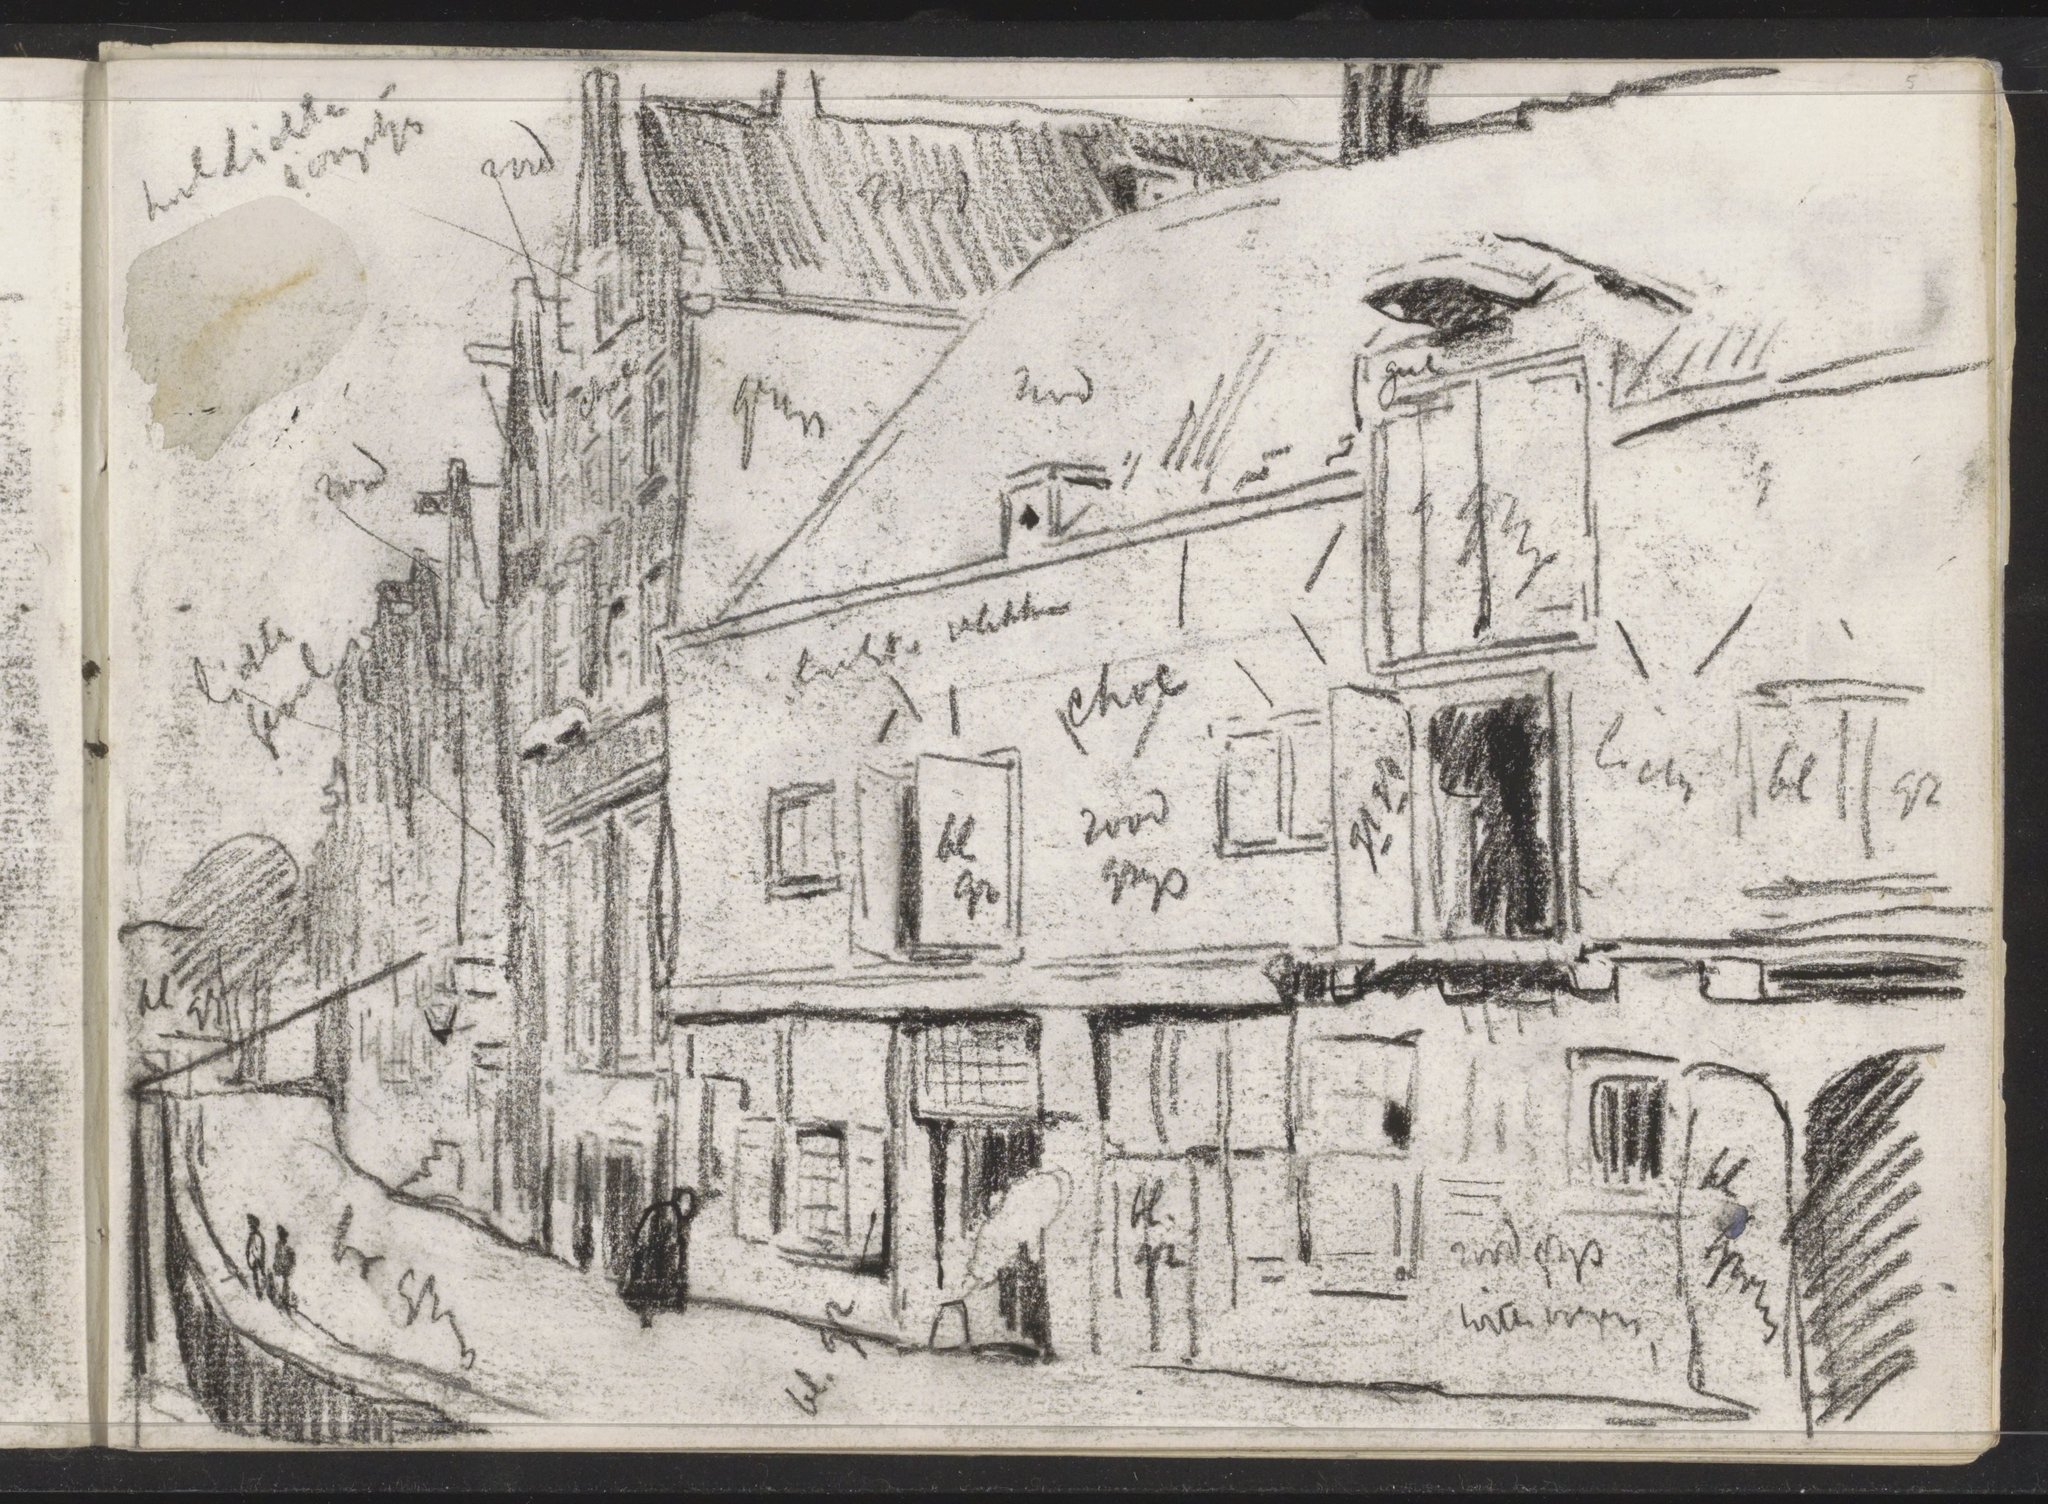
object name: sketchbook leaf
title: Gezicht op een kade met huizen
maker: willem witsen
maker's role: draughtsman, painter, print maker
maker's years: 1860-1923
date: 1897-1899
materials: chalk, paper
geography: amsterdam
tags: canals, waters (in city), civic architecture; edifices; dwellings, amsterdam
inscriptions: kleurnotitie, handgeschreven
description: Pagina 5 uit een schetsboek met 17 bladen.